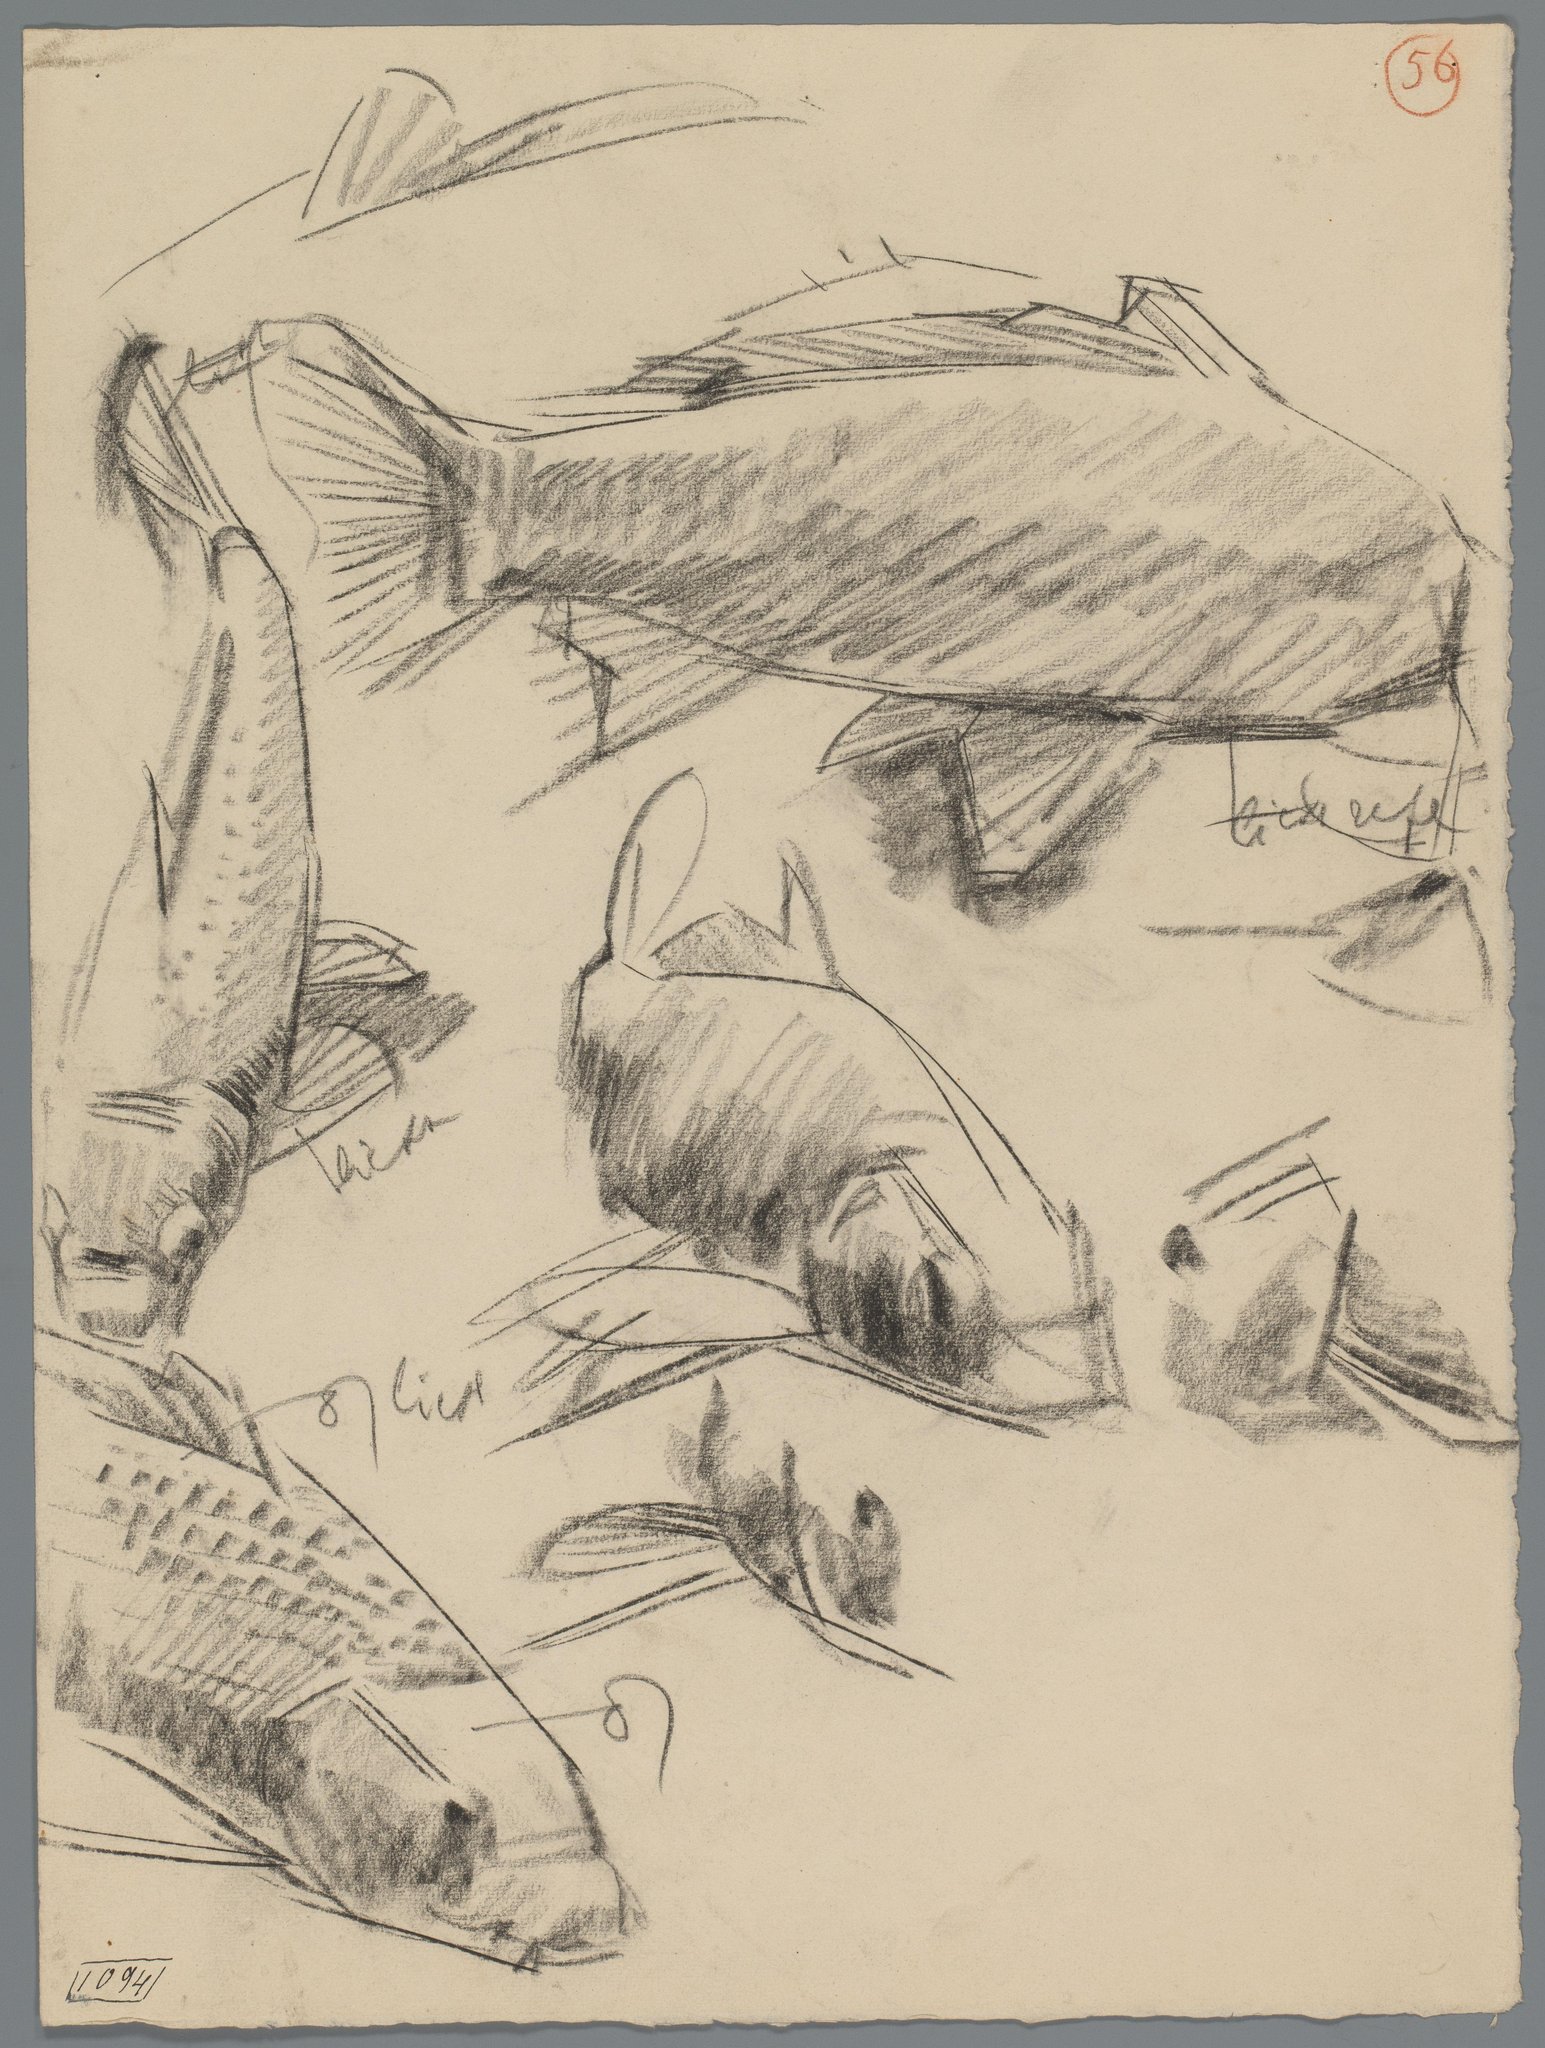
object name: drawing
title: Studies van karpers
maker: gerrit willem dijsselhof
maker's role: designer, draughtsman, print maker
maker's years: 1866-1924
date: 1876-1924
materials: chalk, paper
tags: bony fishes: carp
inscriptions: number: ‘1094’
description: Met aantekeningen. Rechtsboven genummerd: 56.